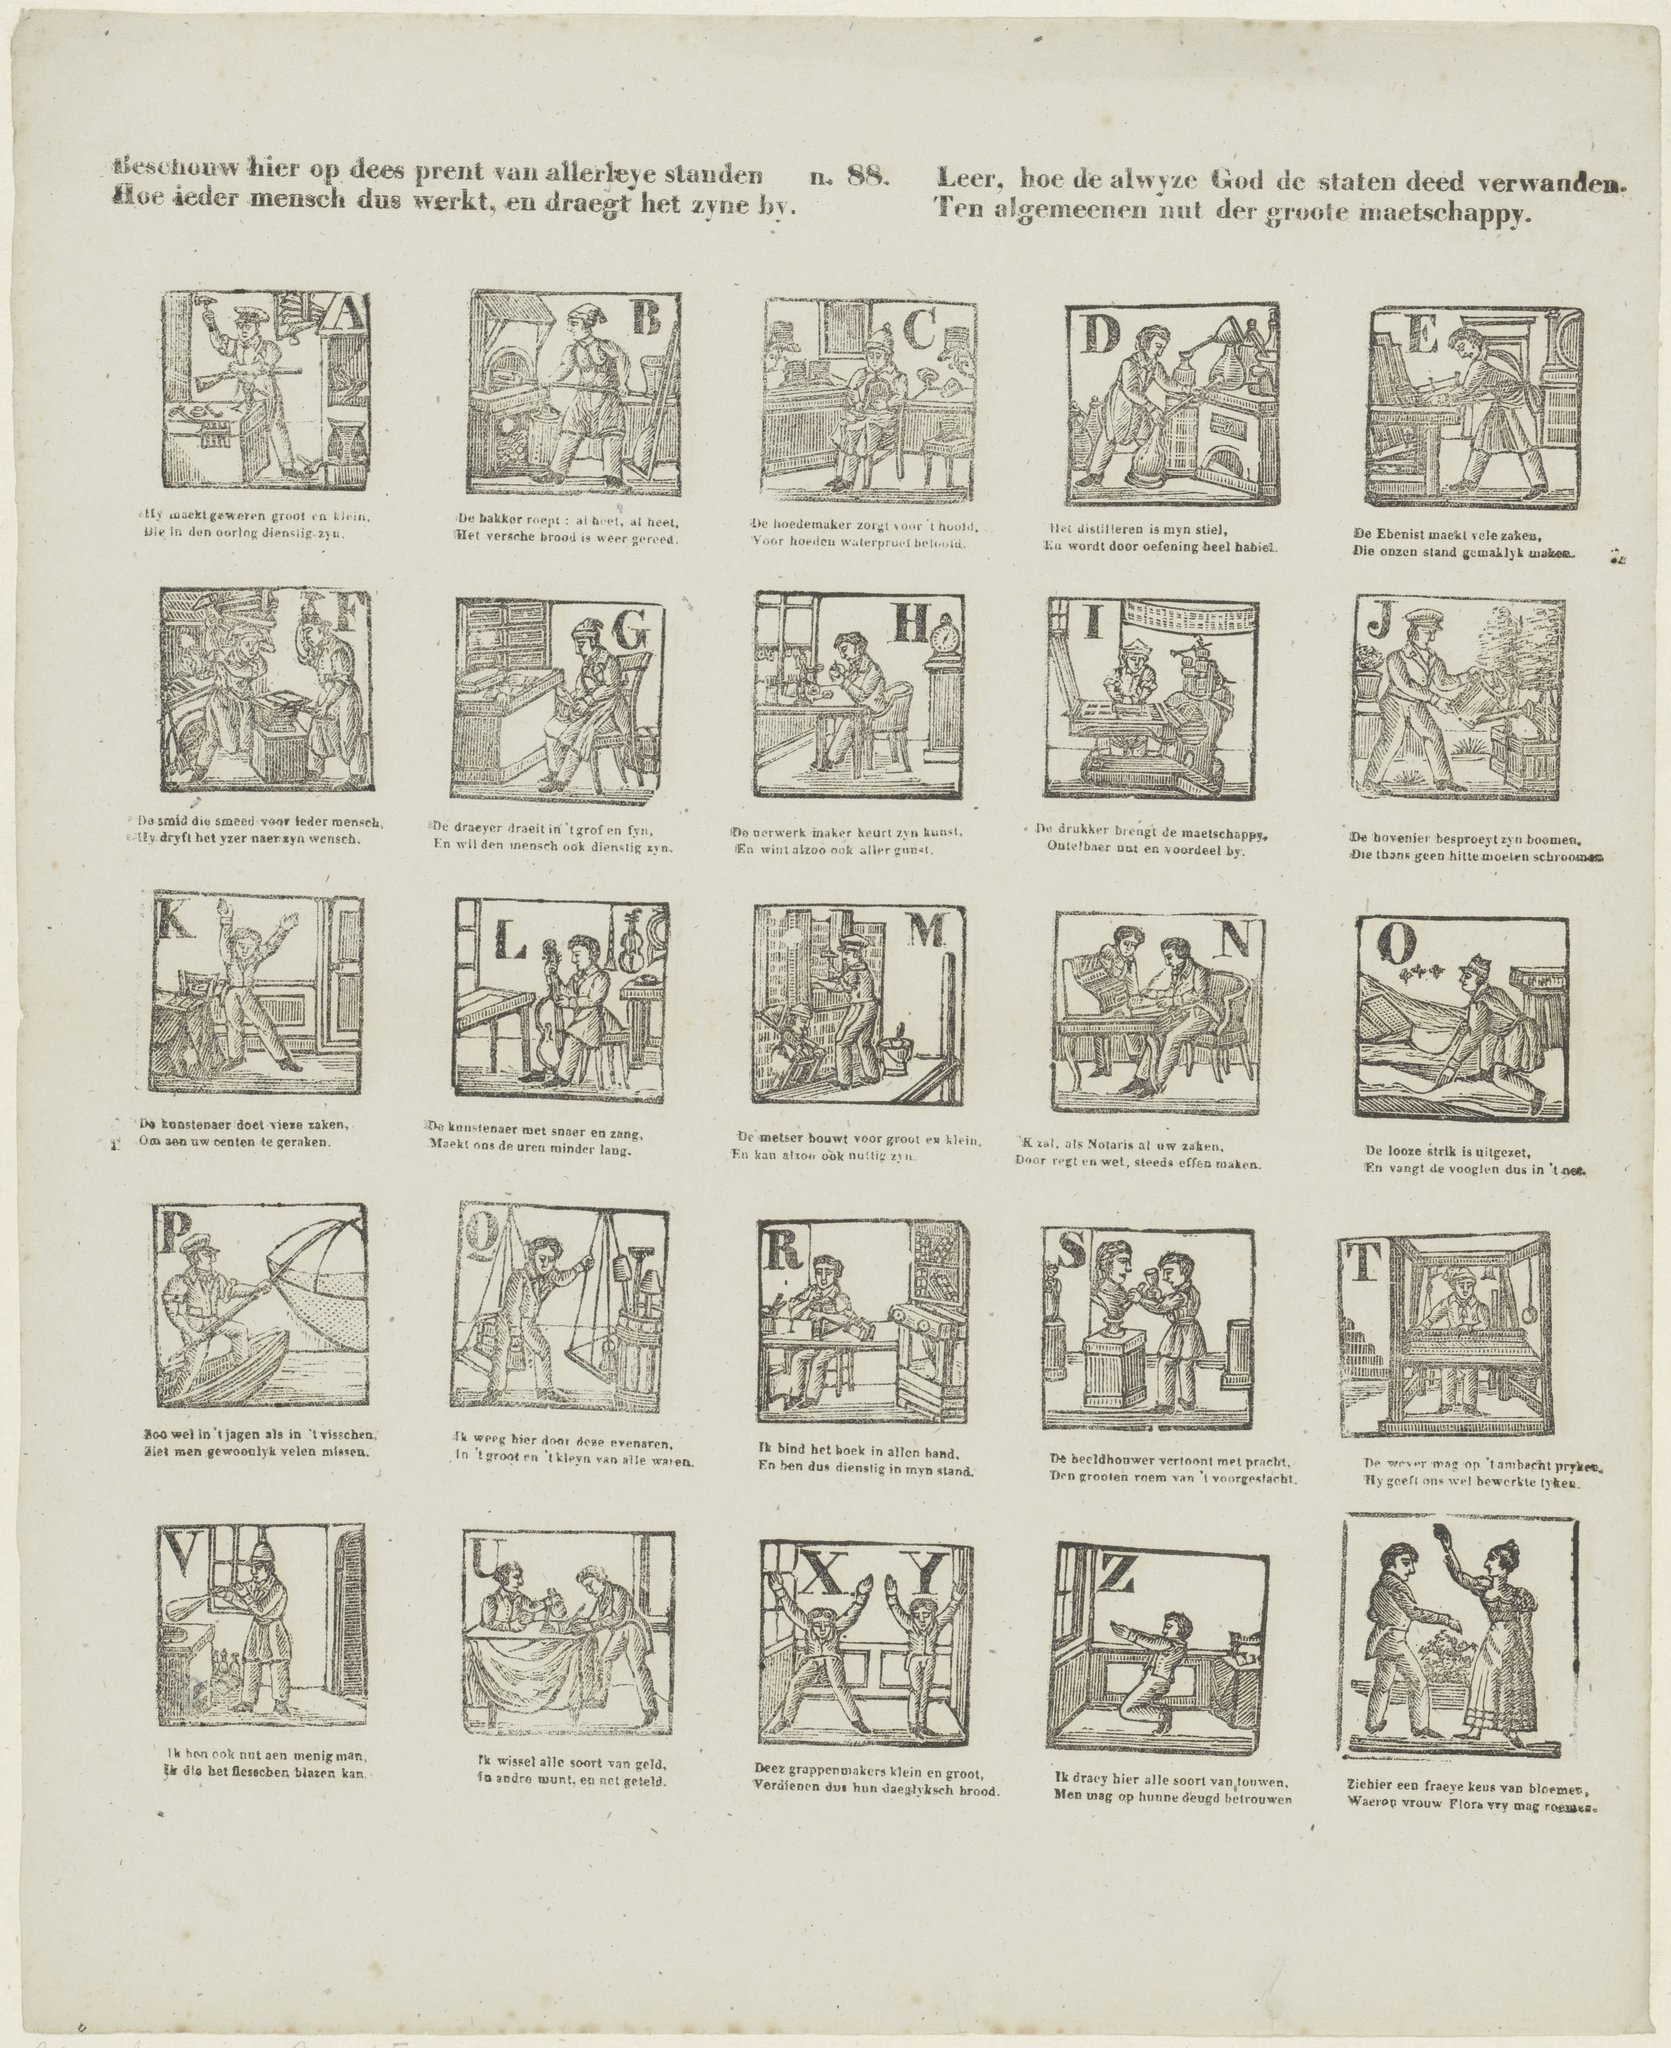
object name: popular print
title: Beschouw hier op dees prent van allerleye standen / Hoe ieder mensch dus werkt, en draegt het zyne by. / Leer, hoe de alwyze God de staten deed verwanden. / Ten algemeenen nut der groote maetschappy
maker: Anonymous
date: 1833-1856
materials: paper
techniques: letterpress printing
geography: netherlands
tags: craft-production, skilled handiwork, letters, alphabet, script, characters (human types), crafts and industries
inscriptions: collector's mark: Lugt 2760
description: Blad met 25 voorstellingen van de letters van het alfabet geïllustreerd met ambachtslieden en figuren waarvan de woorden met de betreffende letter beginnen. Onder elke afbeelding een tweeregelig vers. Genummerd midden boven: n. 88.